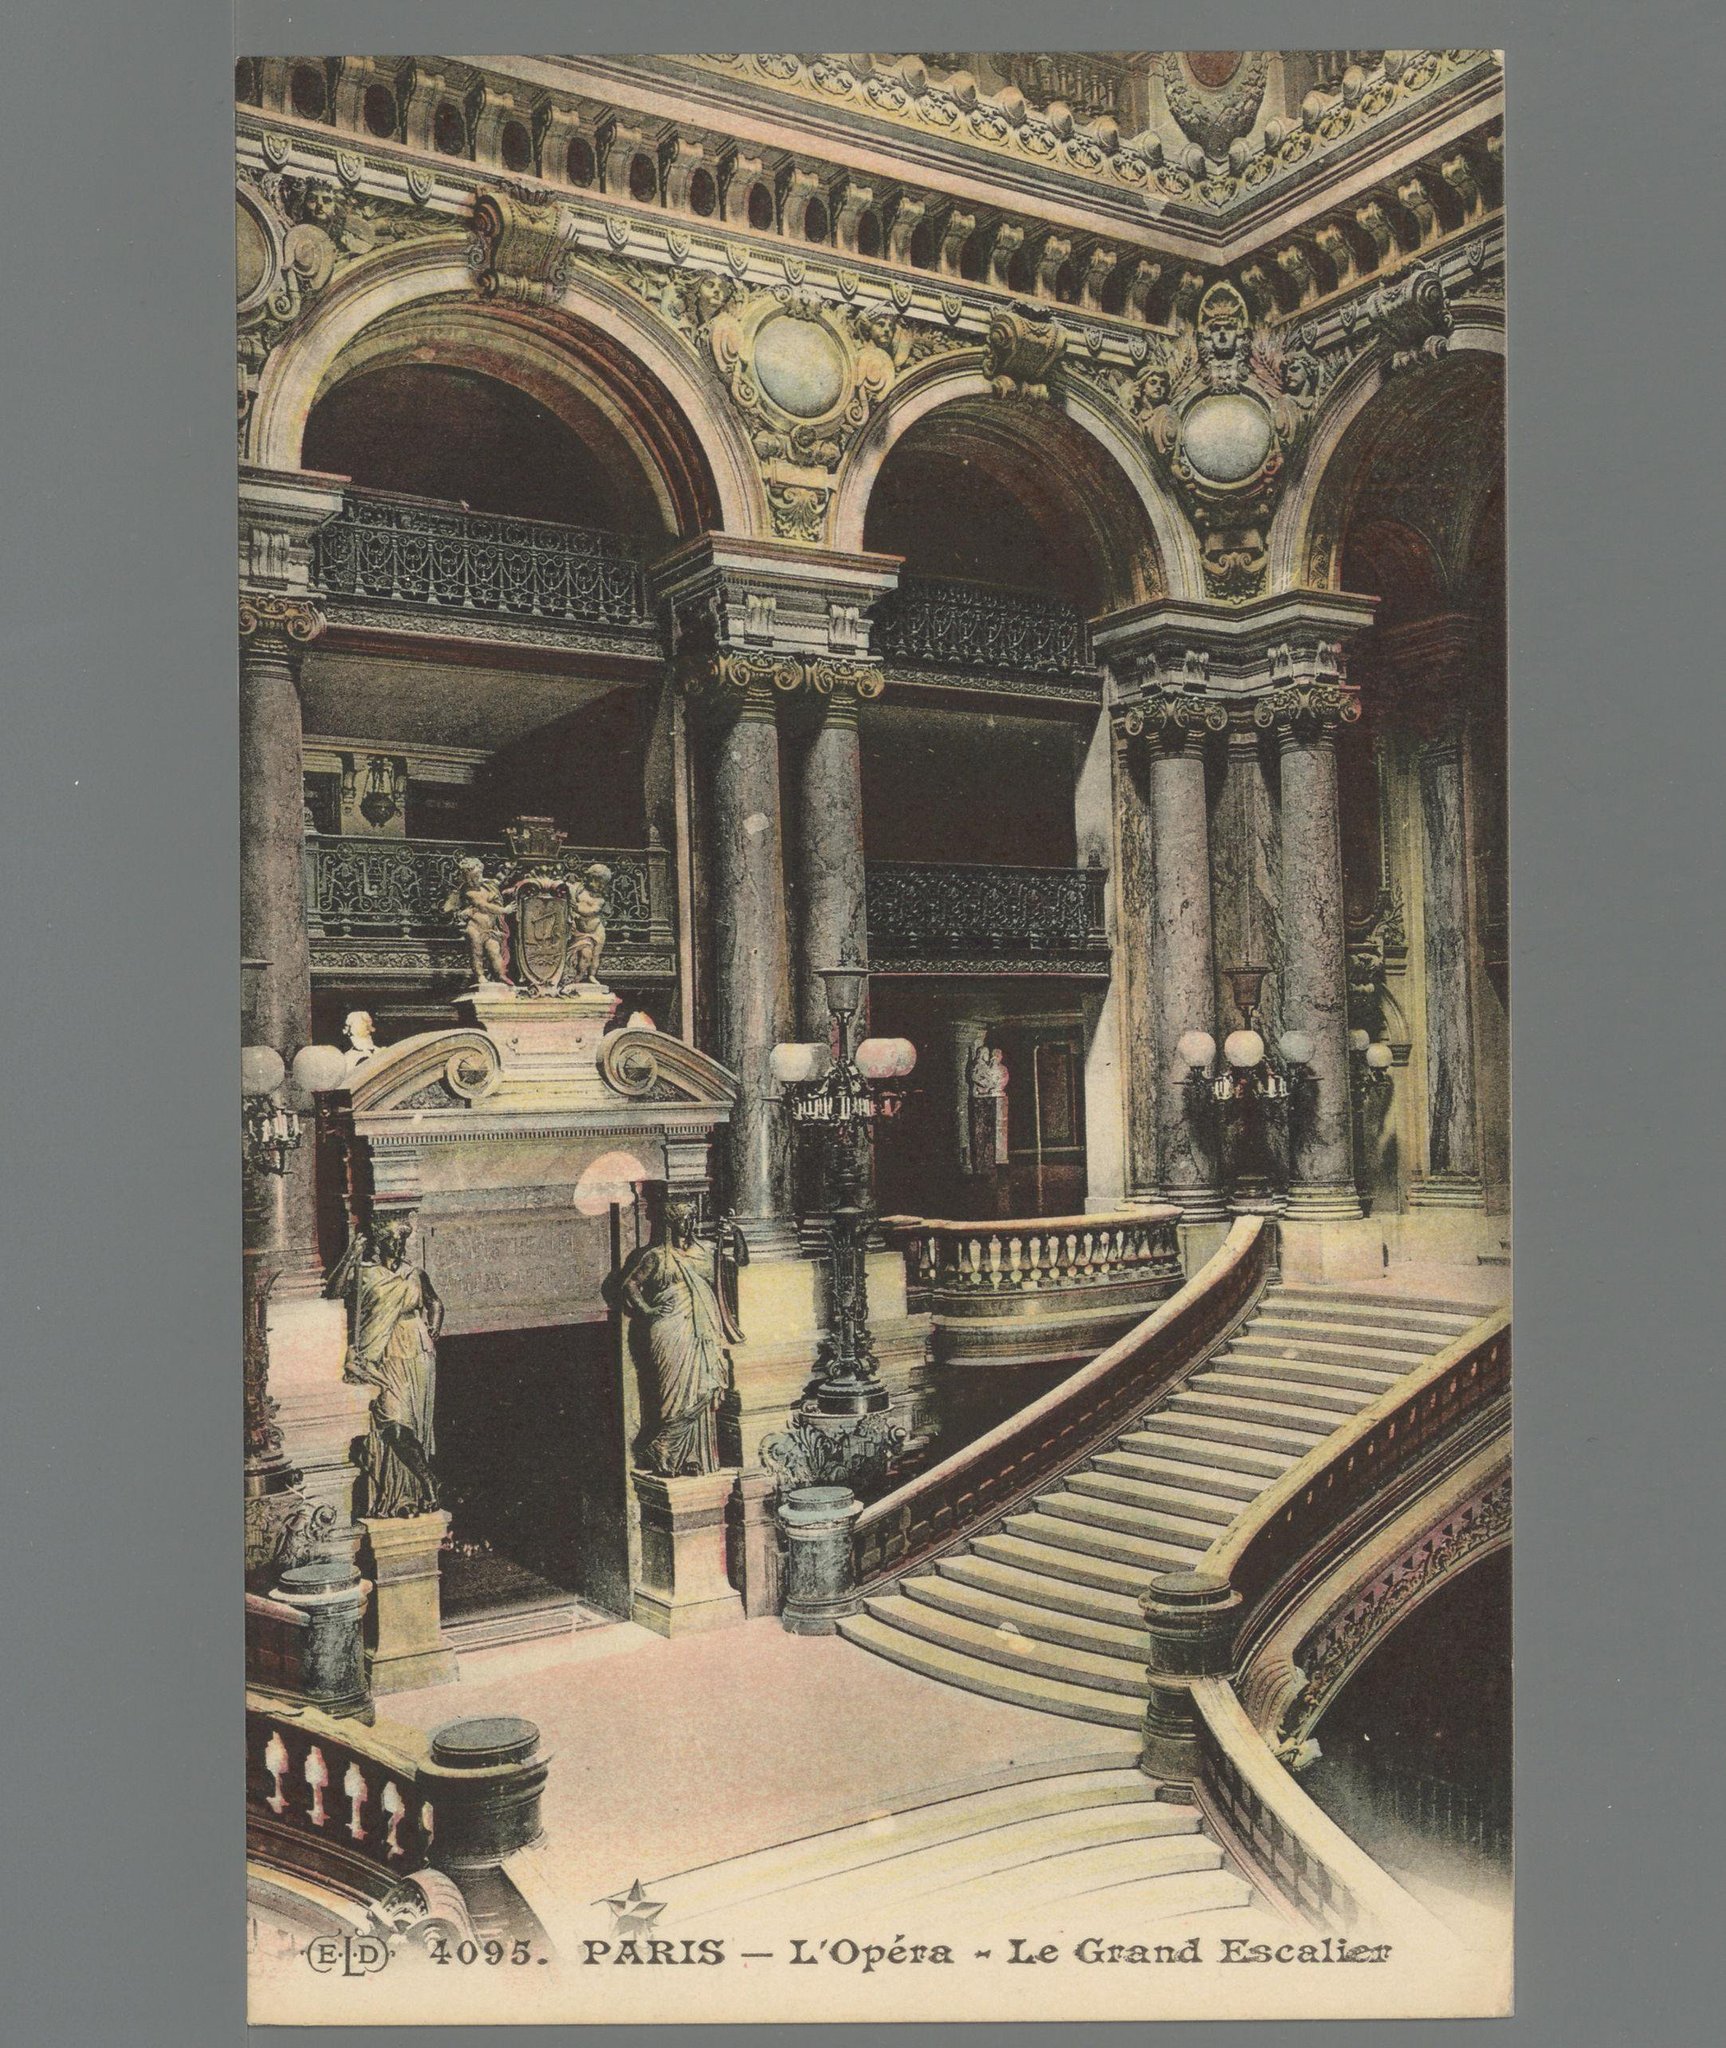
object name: photomechanical print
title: Paris. L'Opéra. Le Grand Escalier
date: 1904-1906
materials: cardboard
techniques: photograph, lithograph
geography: paris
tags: staircase, interior ~ representation of a building, opera house